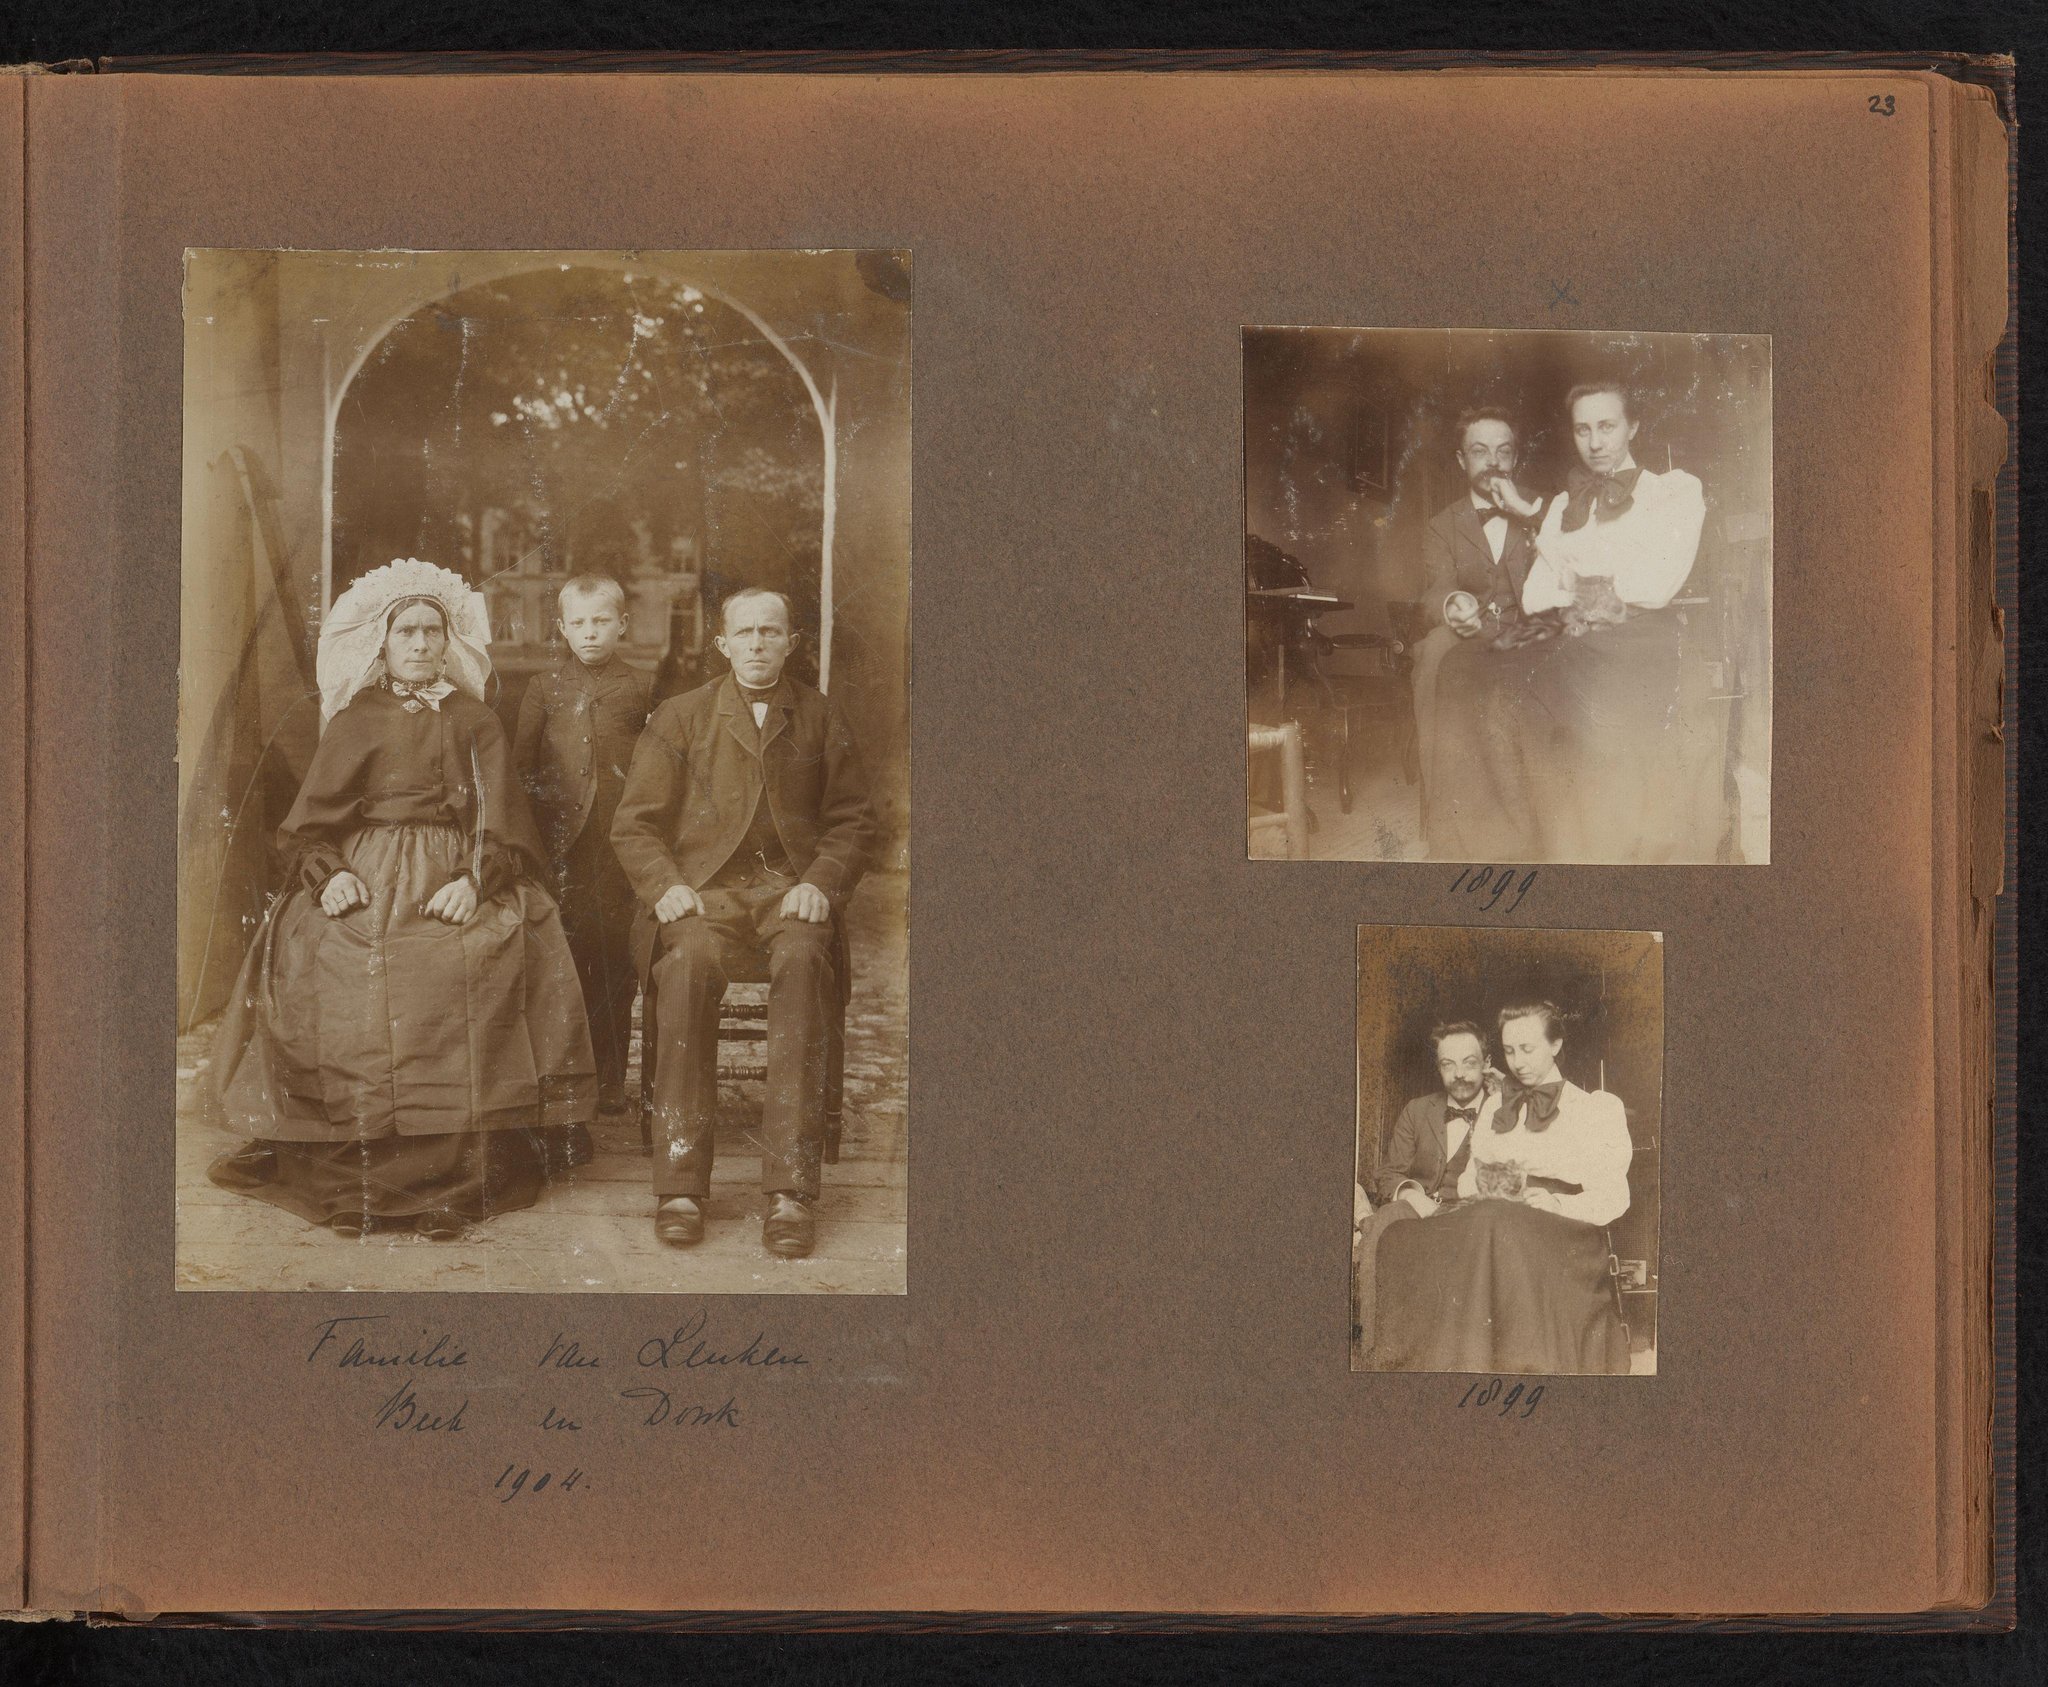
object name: photograph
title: Bladzijde uit het fotoalbum van de familie Diepenbrock met 3 foto's van Alphons Diepenbrock en zijn omgeving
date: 1899-1904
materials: cardboard, photographic support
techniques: photography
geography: amsterdam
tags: alphons diepenbrock, jonkvrouw wilhelmina elisabeth petronella cornelia de jong van beek en donk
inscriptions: inscription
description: Bruin albumblad 23 van familiealbum van Alphons Diepenbrock.